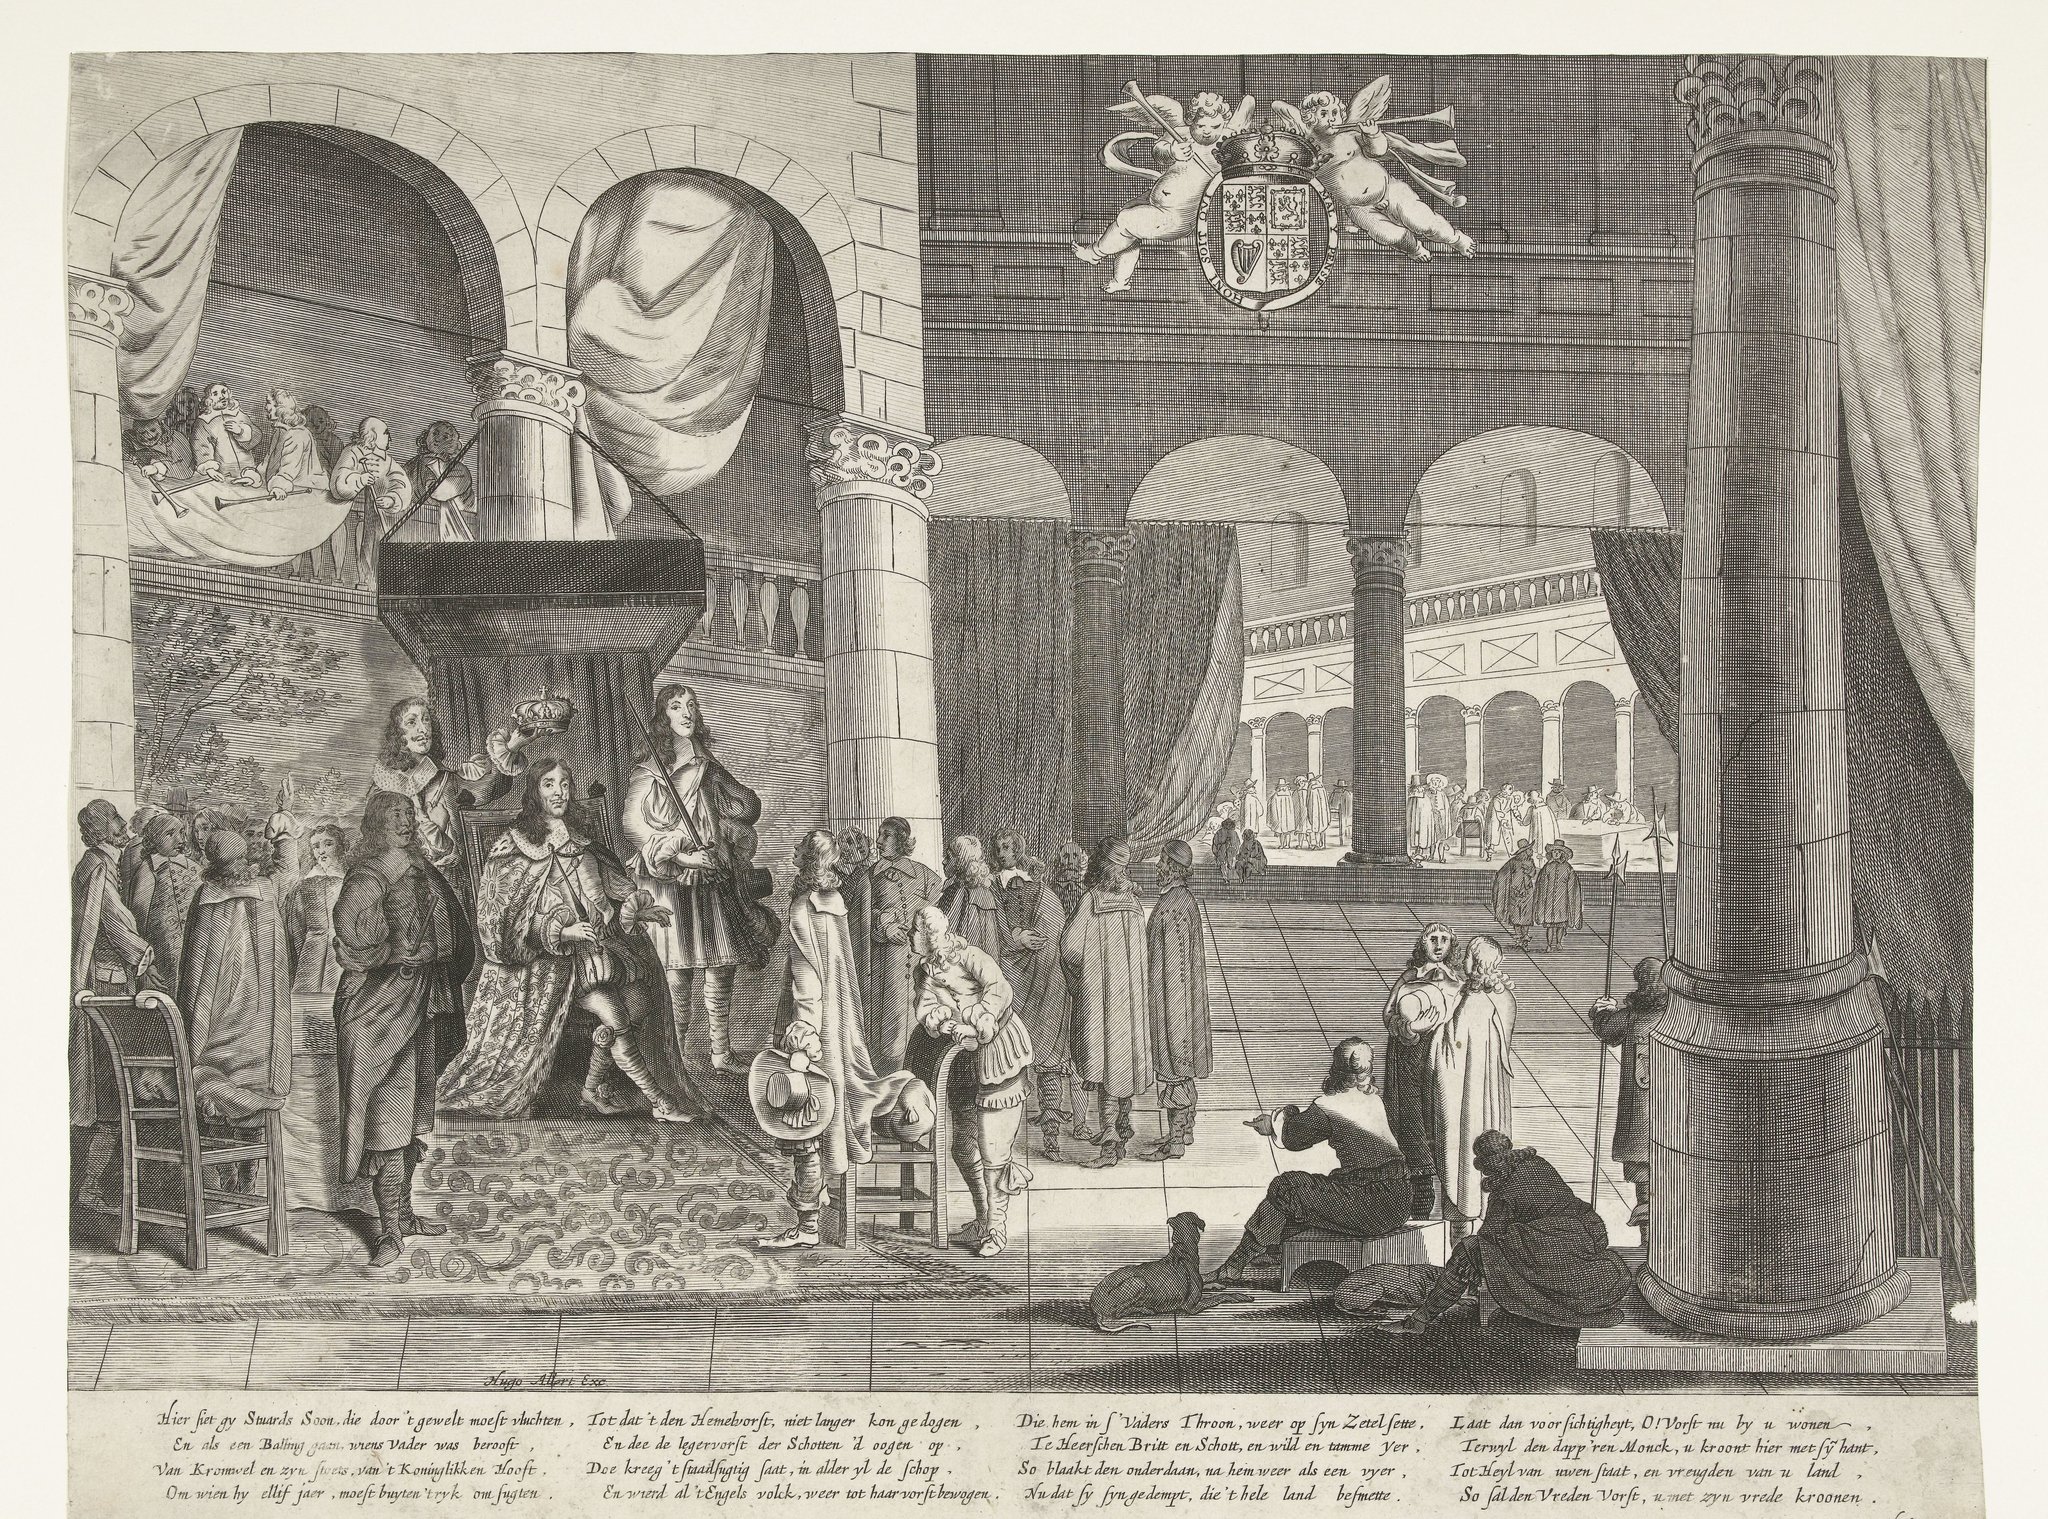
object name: print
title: Karel II door admiraal Monck tot koning van Engeland gekroond, 1661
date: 1660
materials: paper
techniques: engraving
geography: northern netherlands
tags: karel ii (koning van engeland), coronation of a ruler, westminster abbey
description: Karel II door admiraal Monck tot koning van Engeland gekroond in Westminster Abbey, 23 april 1661. Open hal of zuilengang in een paleis met de koning zittend op zijn troon. Bovenaan twee engelen met het wapen van Engeland. In het onderschrift vier vierregelige verzen.